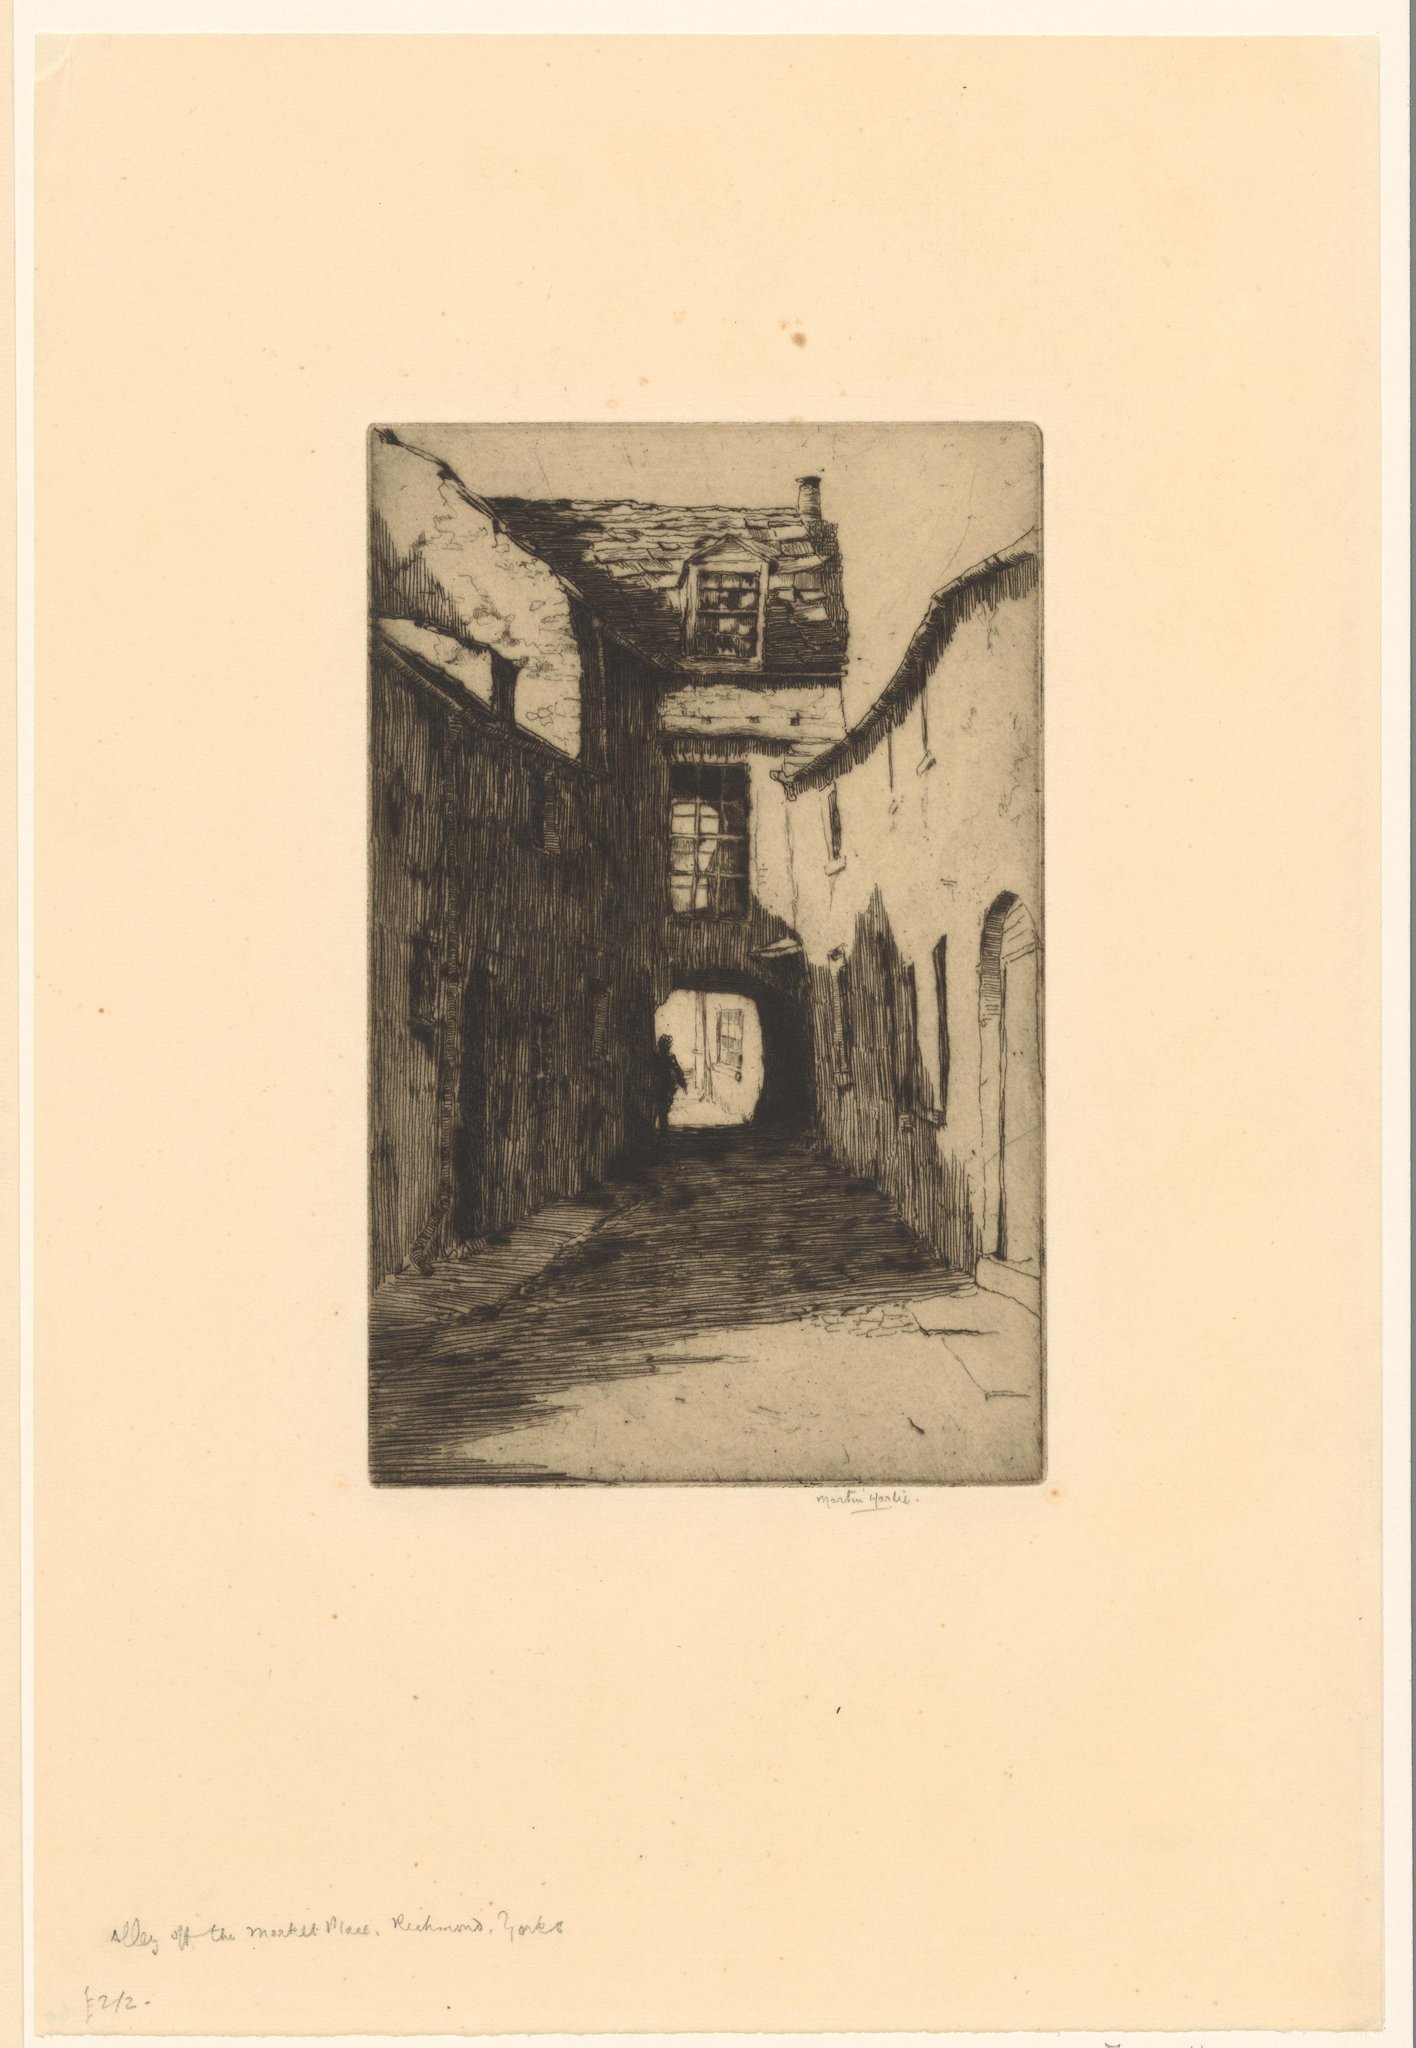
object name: print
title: Smalle straat in Richmond naar het marktplein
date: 1913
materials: paper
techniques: drypoint, etching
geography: richmond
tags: street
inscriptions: annotation: ‘Martin Hardie’, collector's mark: Lugt 2760, collector's mark: Lugt 2228